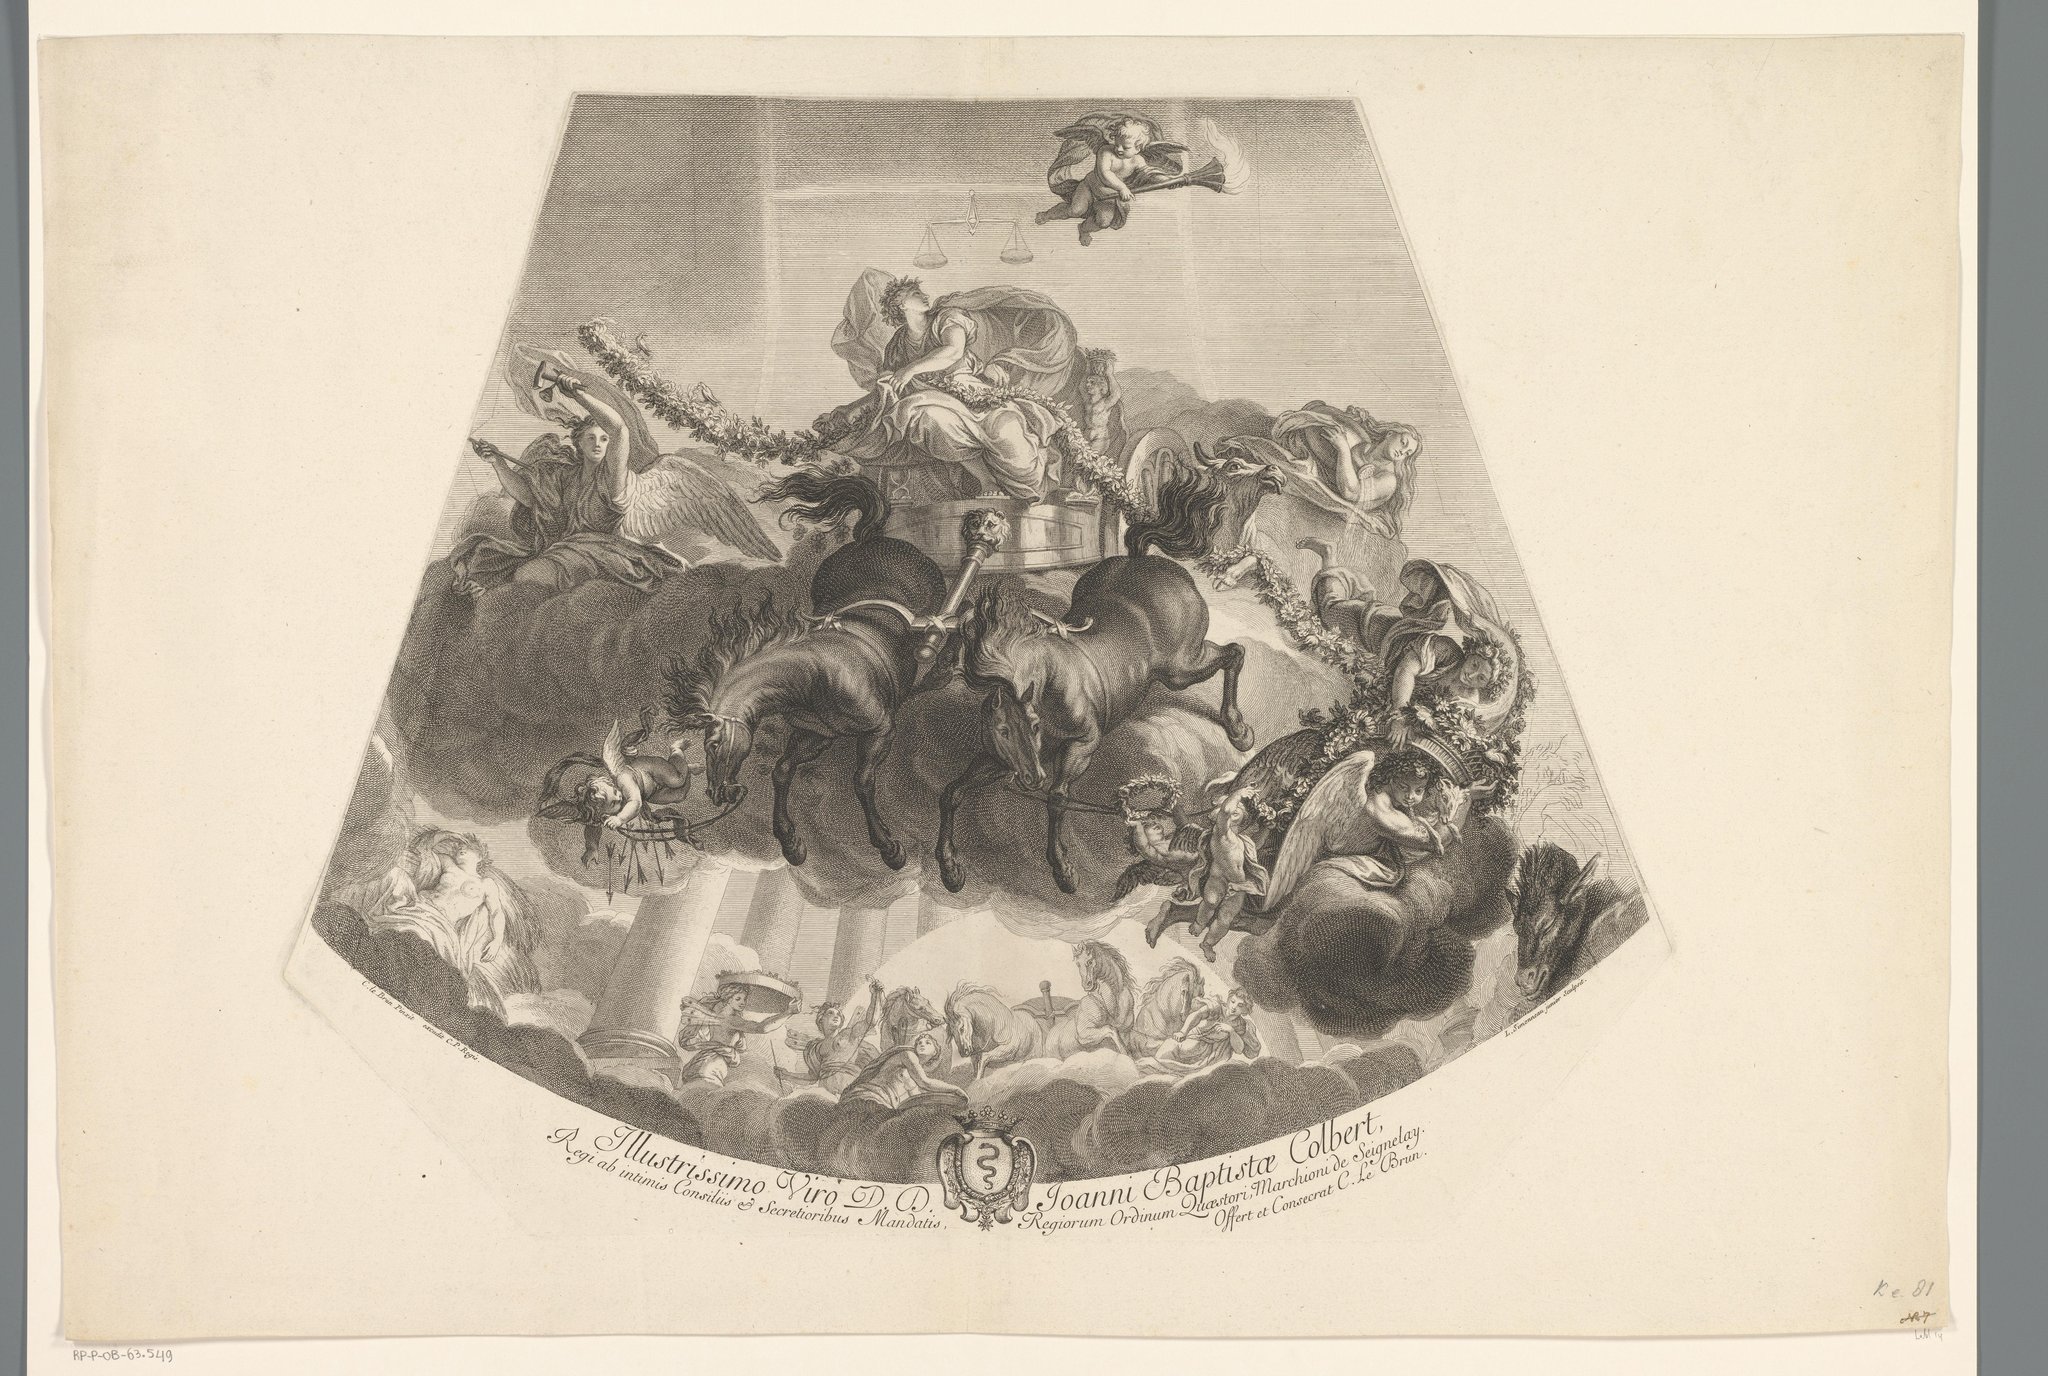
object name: print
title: Aurora verjaagt de nacht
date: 1673-1683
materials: paper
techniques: engraving, etching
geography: france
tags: triumph of aurora: in her chariot drawn by two (sometimes four) horses, and possibly scattering flowers; aurora's victory over the night; 'carro dell'aurora' (ripa)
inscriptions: collector's mark: Lugt 240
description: Naar een plafondschildering van het paviljoen van Aurora in kasteel de Sceaux, uitgevoerd in ca. 1673-1674.